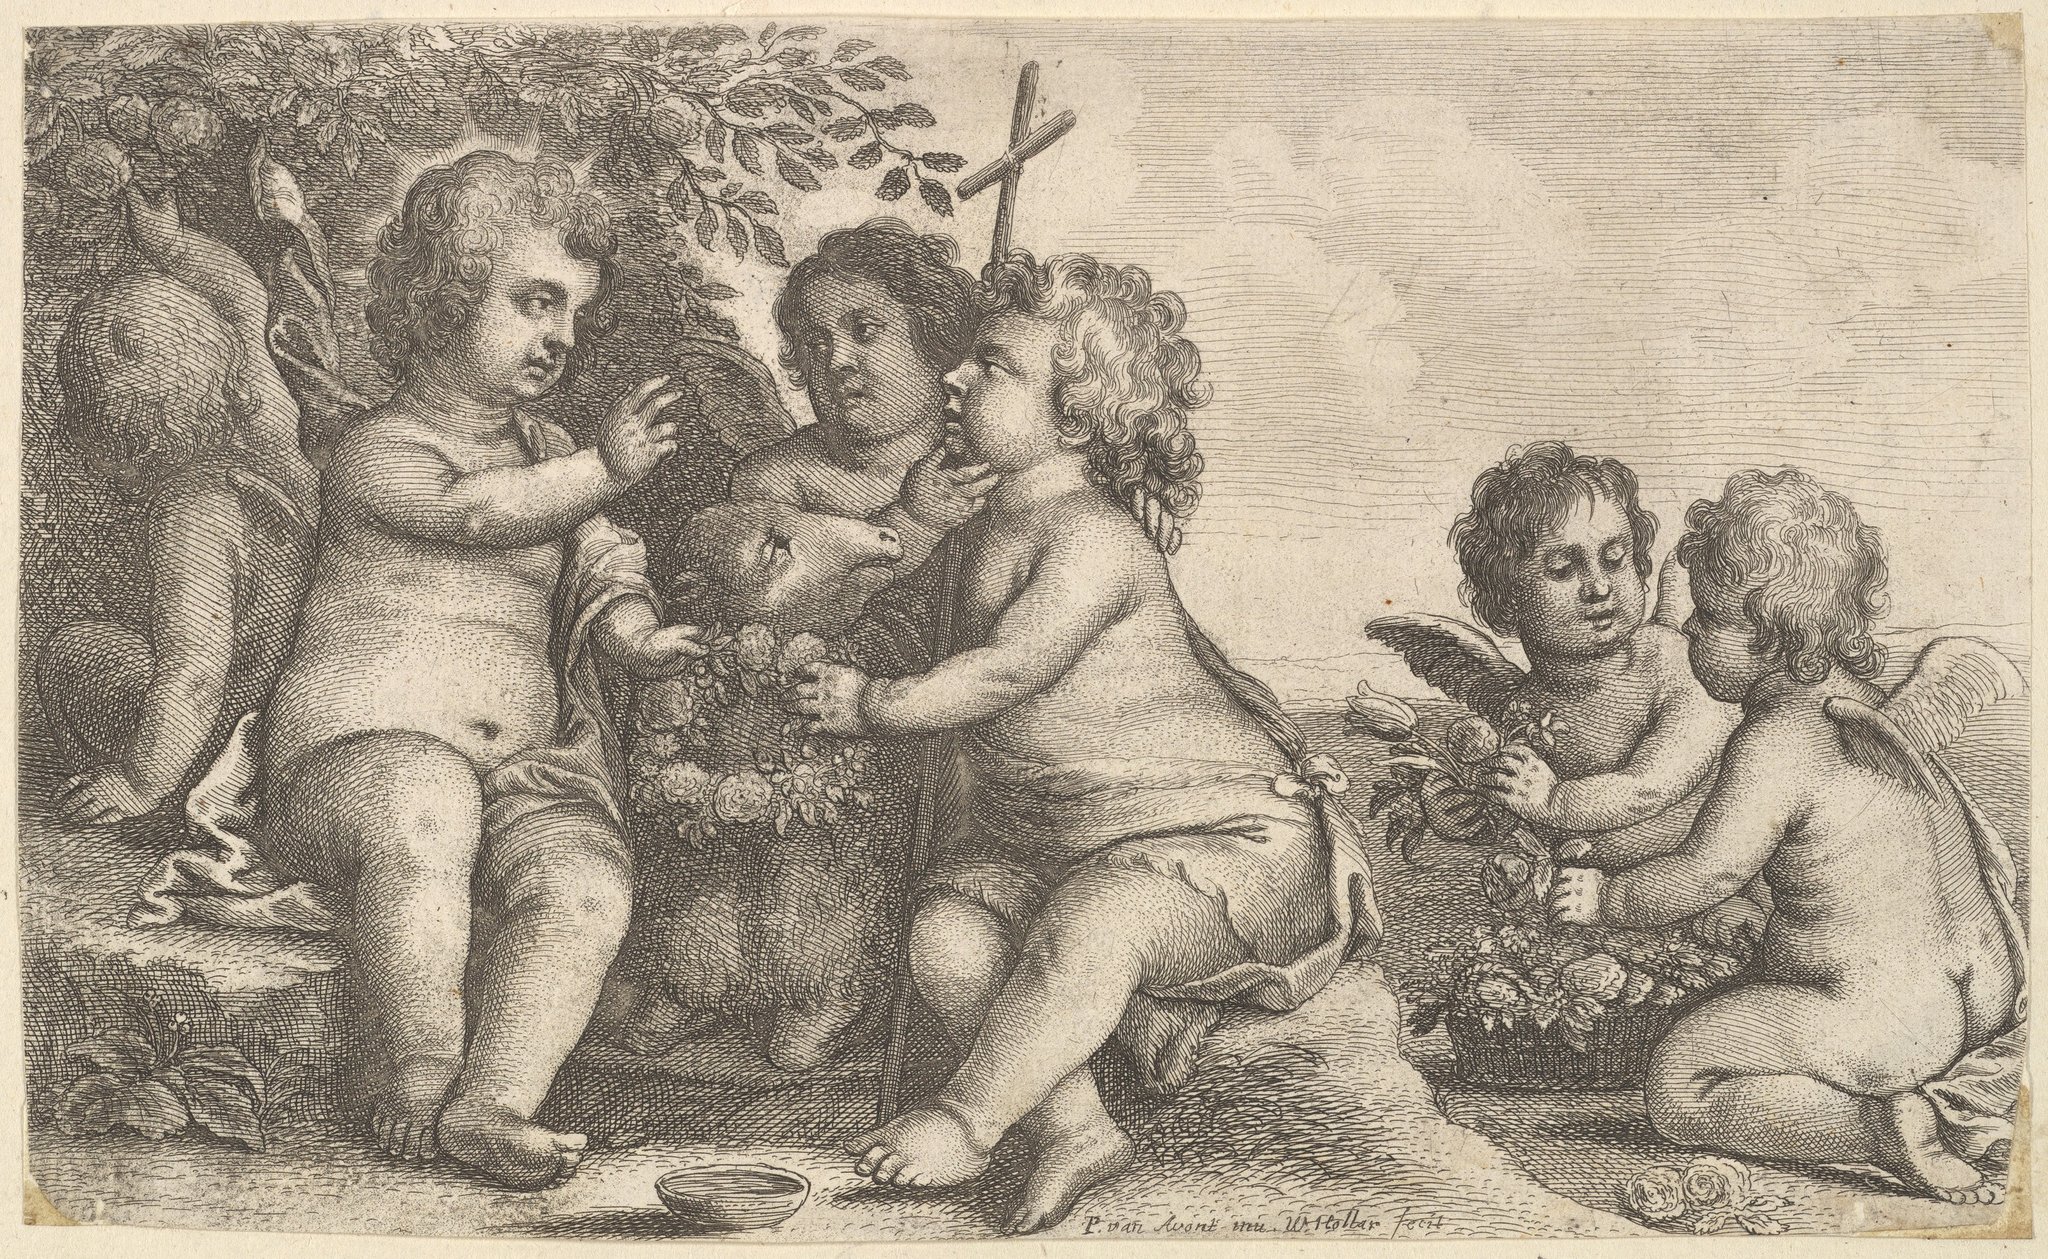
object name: print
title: Jesus, St. John the Baptist and four cherubs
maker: wenceslaus hollar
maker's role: artist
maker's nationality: bohemian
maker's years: 1607-1677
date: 1646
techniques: etching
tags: saint john the baptist,jesus